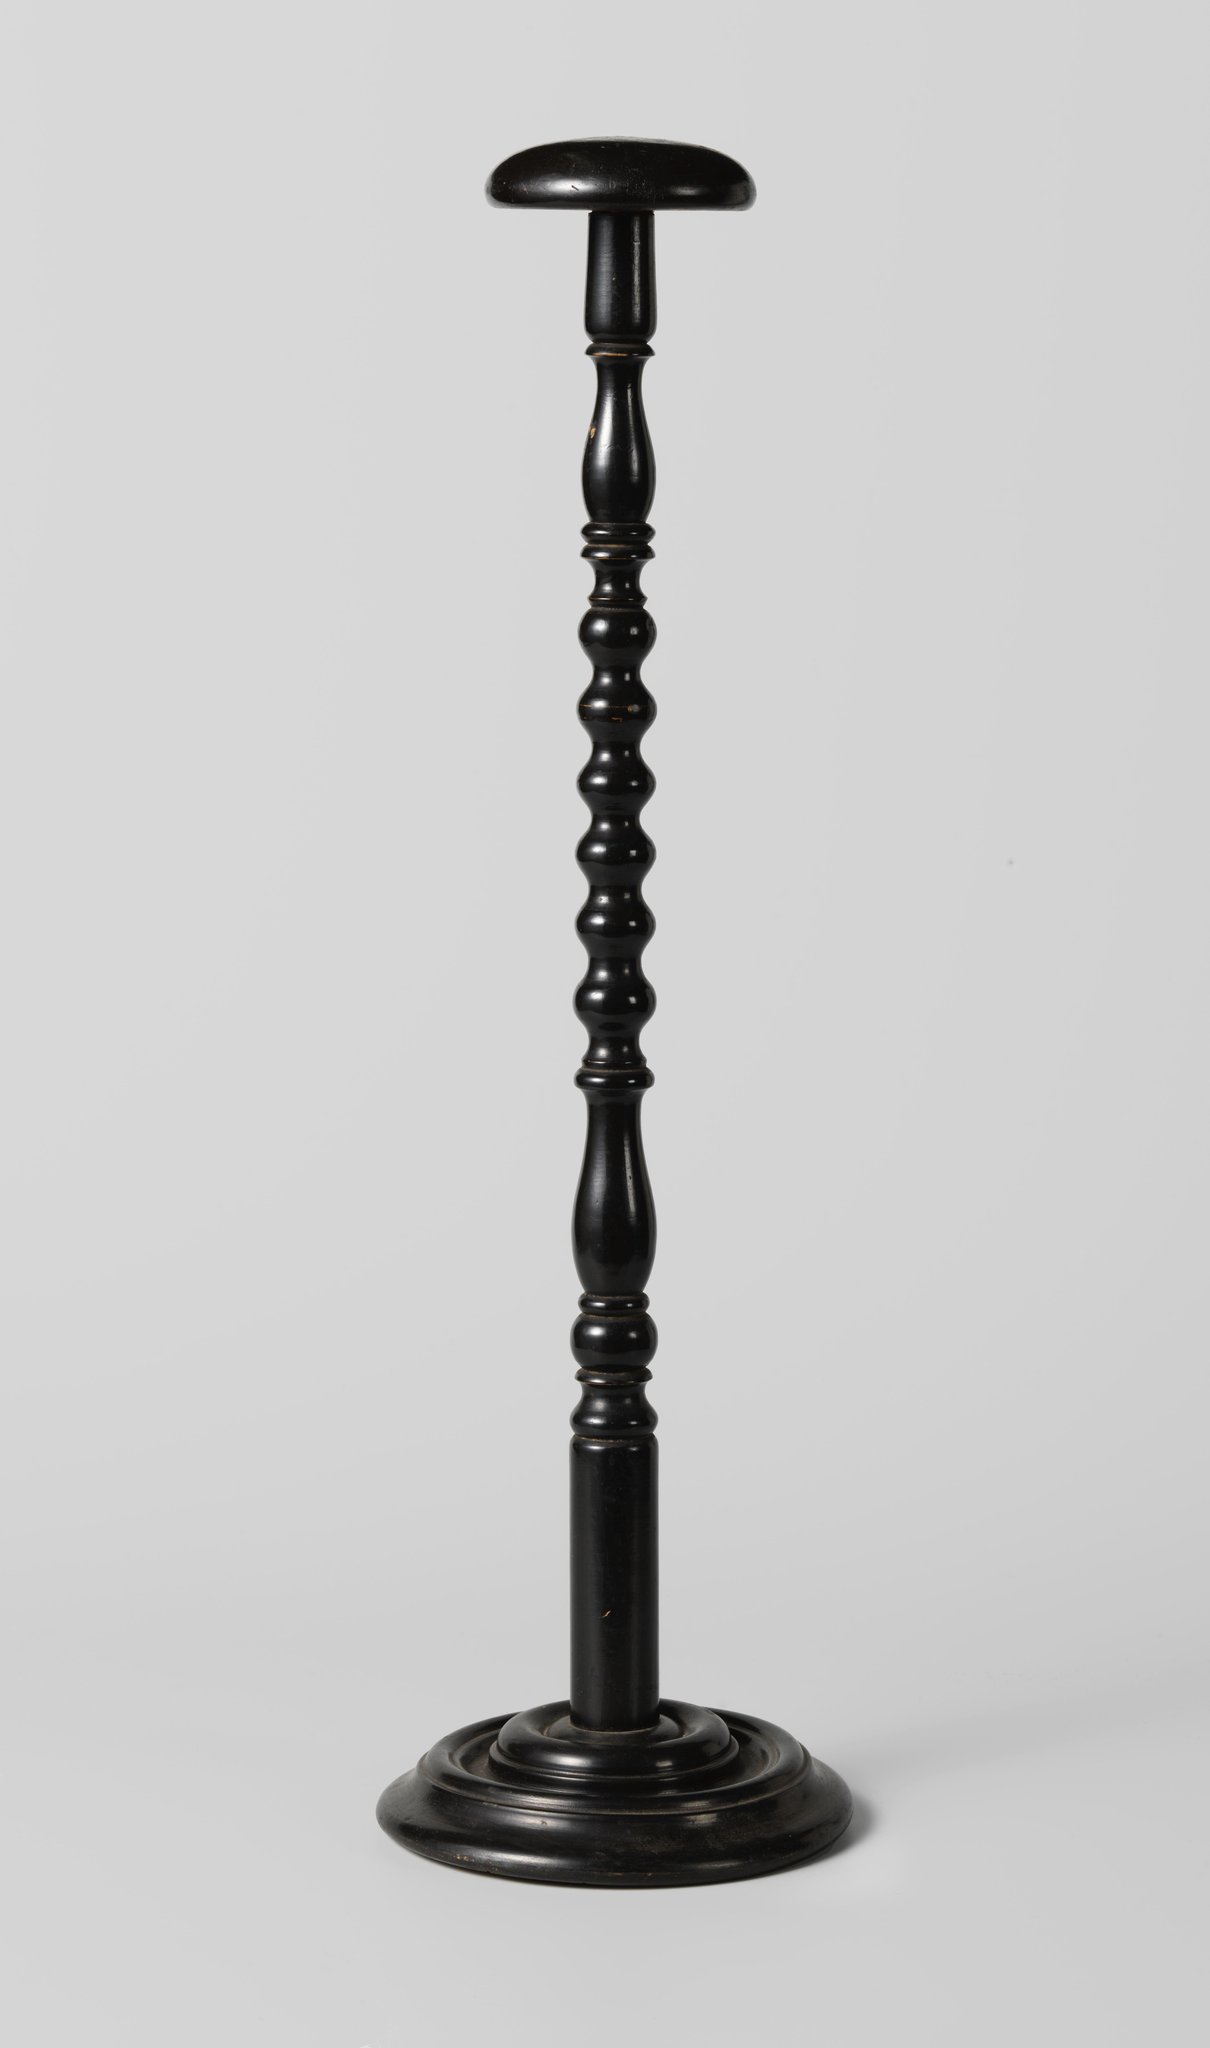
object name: stand support object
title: Standaard van het hoofdstel van het paard Alice dat op 12 augustus 1831 door de prins van Oranje werd bereden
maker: Anonymous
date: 1831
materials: wood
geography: netherlands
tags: alexander (prins der nederlanden, prins van oranje-nassau)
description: Houten zwart geverfde standaarden bestaande uit één lange en twee kortere delen met een breed rond voetstuk en een smaller rond topstuk waartussen een besneden gedraaide staak is bevestigd. Aan de standaard zit een papier met een lakzegel en een beschrijving van de herkomst van het object. Van het paard werd op bovengenoemde datum bij Bautersem door een kanonskogel het rechter voorbeen afgeschoten.